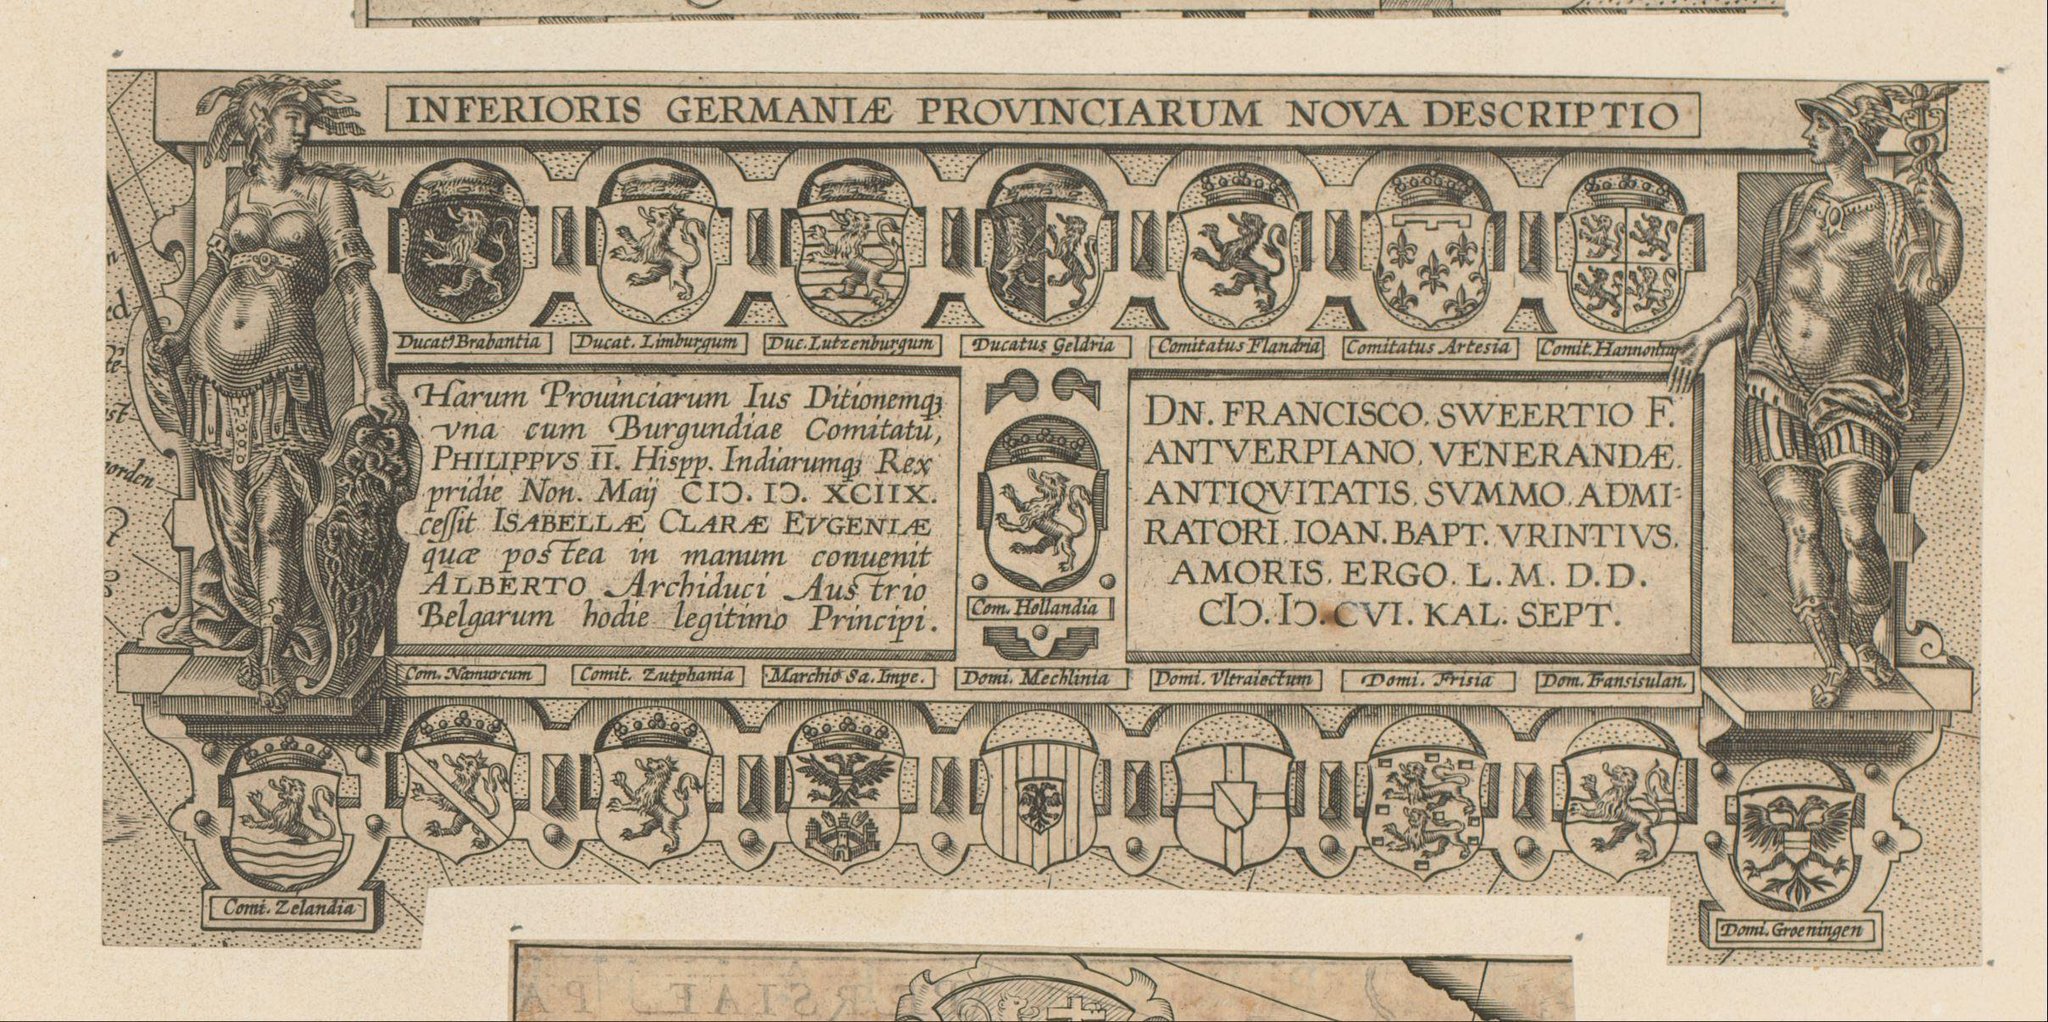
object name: print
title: Inferioris Germaniae Provinciarum Nova Descriptio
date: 1606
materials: paper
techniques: engraving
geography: antwerp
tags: coat of arms (as symbol of the state, etc.), (story of) minerva (pallas, athena), (story of) mercury (hermes), ornament ~ cartouche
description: Langwerpige cartouche van een kaart van de Zeventien Nederlandse Provinciën. De cartouche is gedecoreerd met de wapen van de zeventien provincies. Links en rechts staan de goden Athena en Mercurius. De prent maakt deel uit van een album.